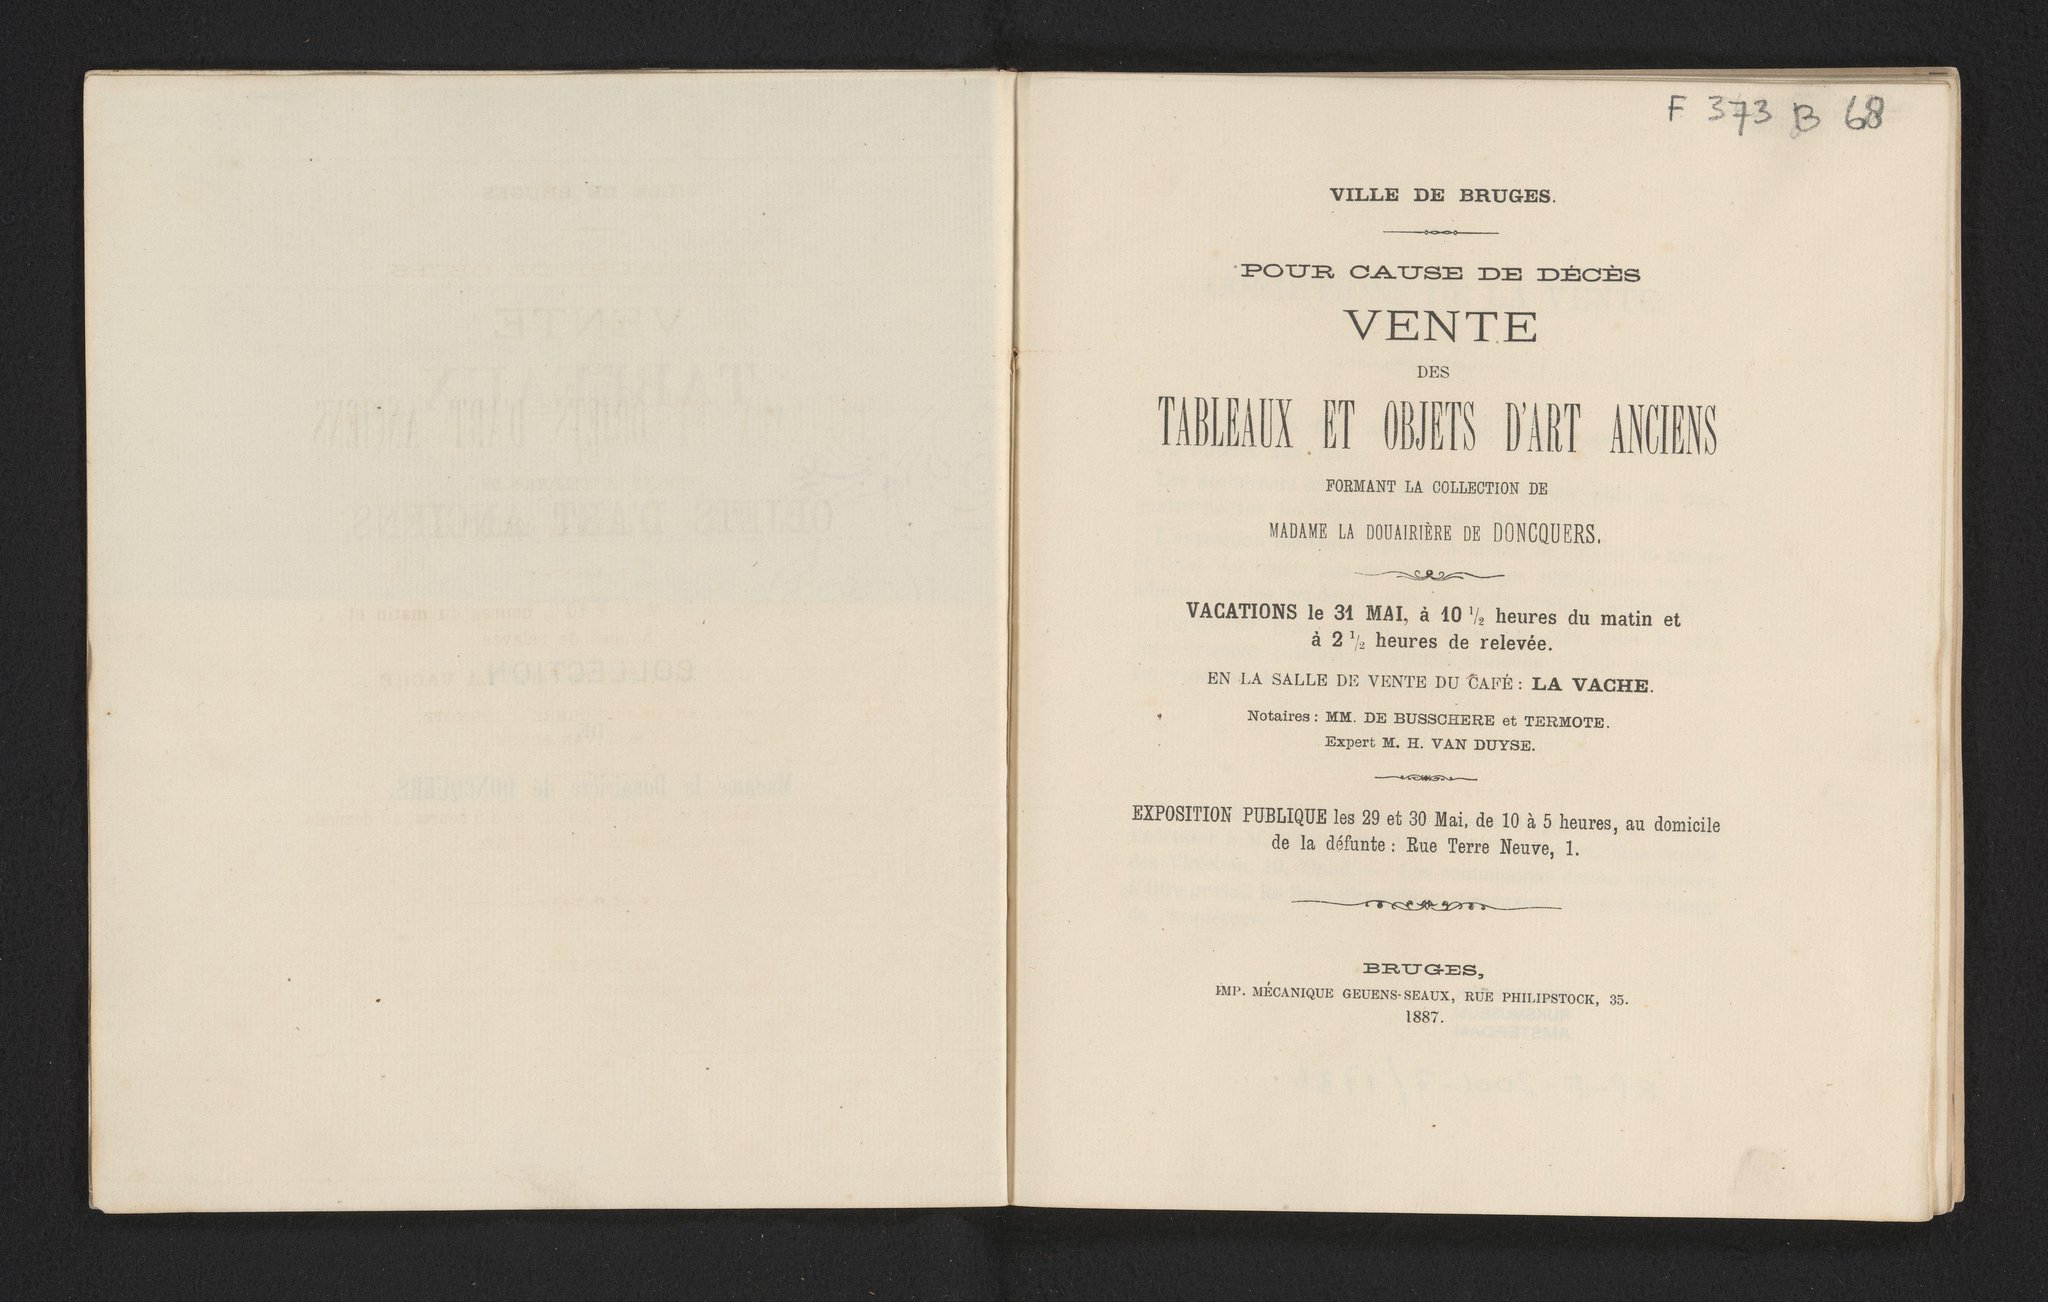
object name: book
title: Vente des tableaux et objets d'art anciens formant la collection de madame la douairière de Doncquers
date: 1887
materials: paper, photographic support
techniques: albumen print, printing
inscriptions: date: ‘OCT/ 1995’